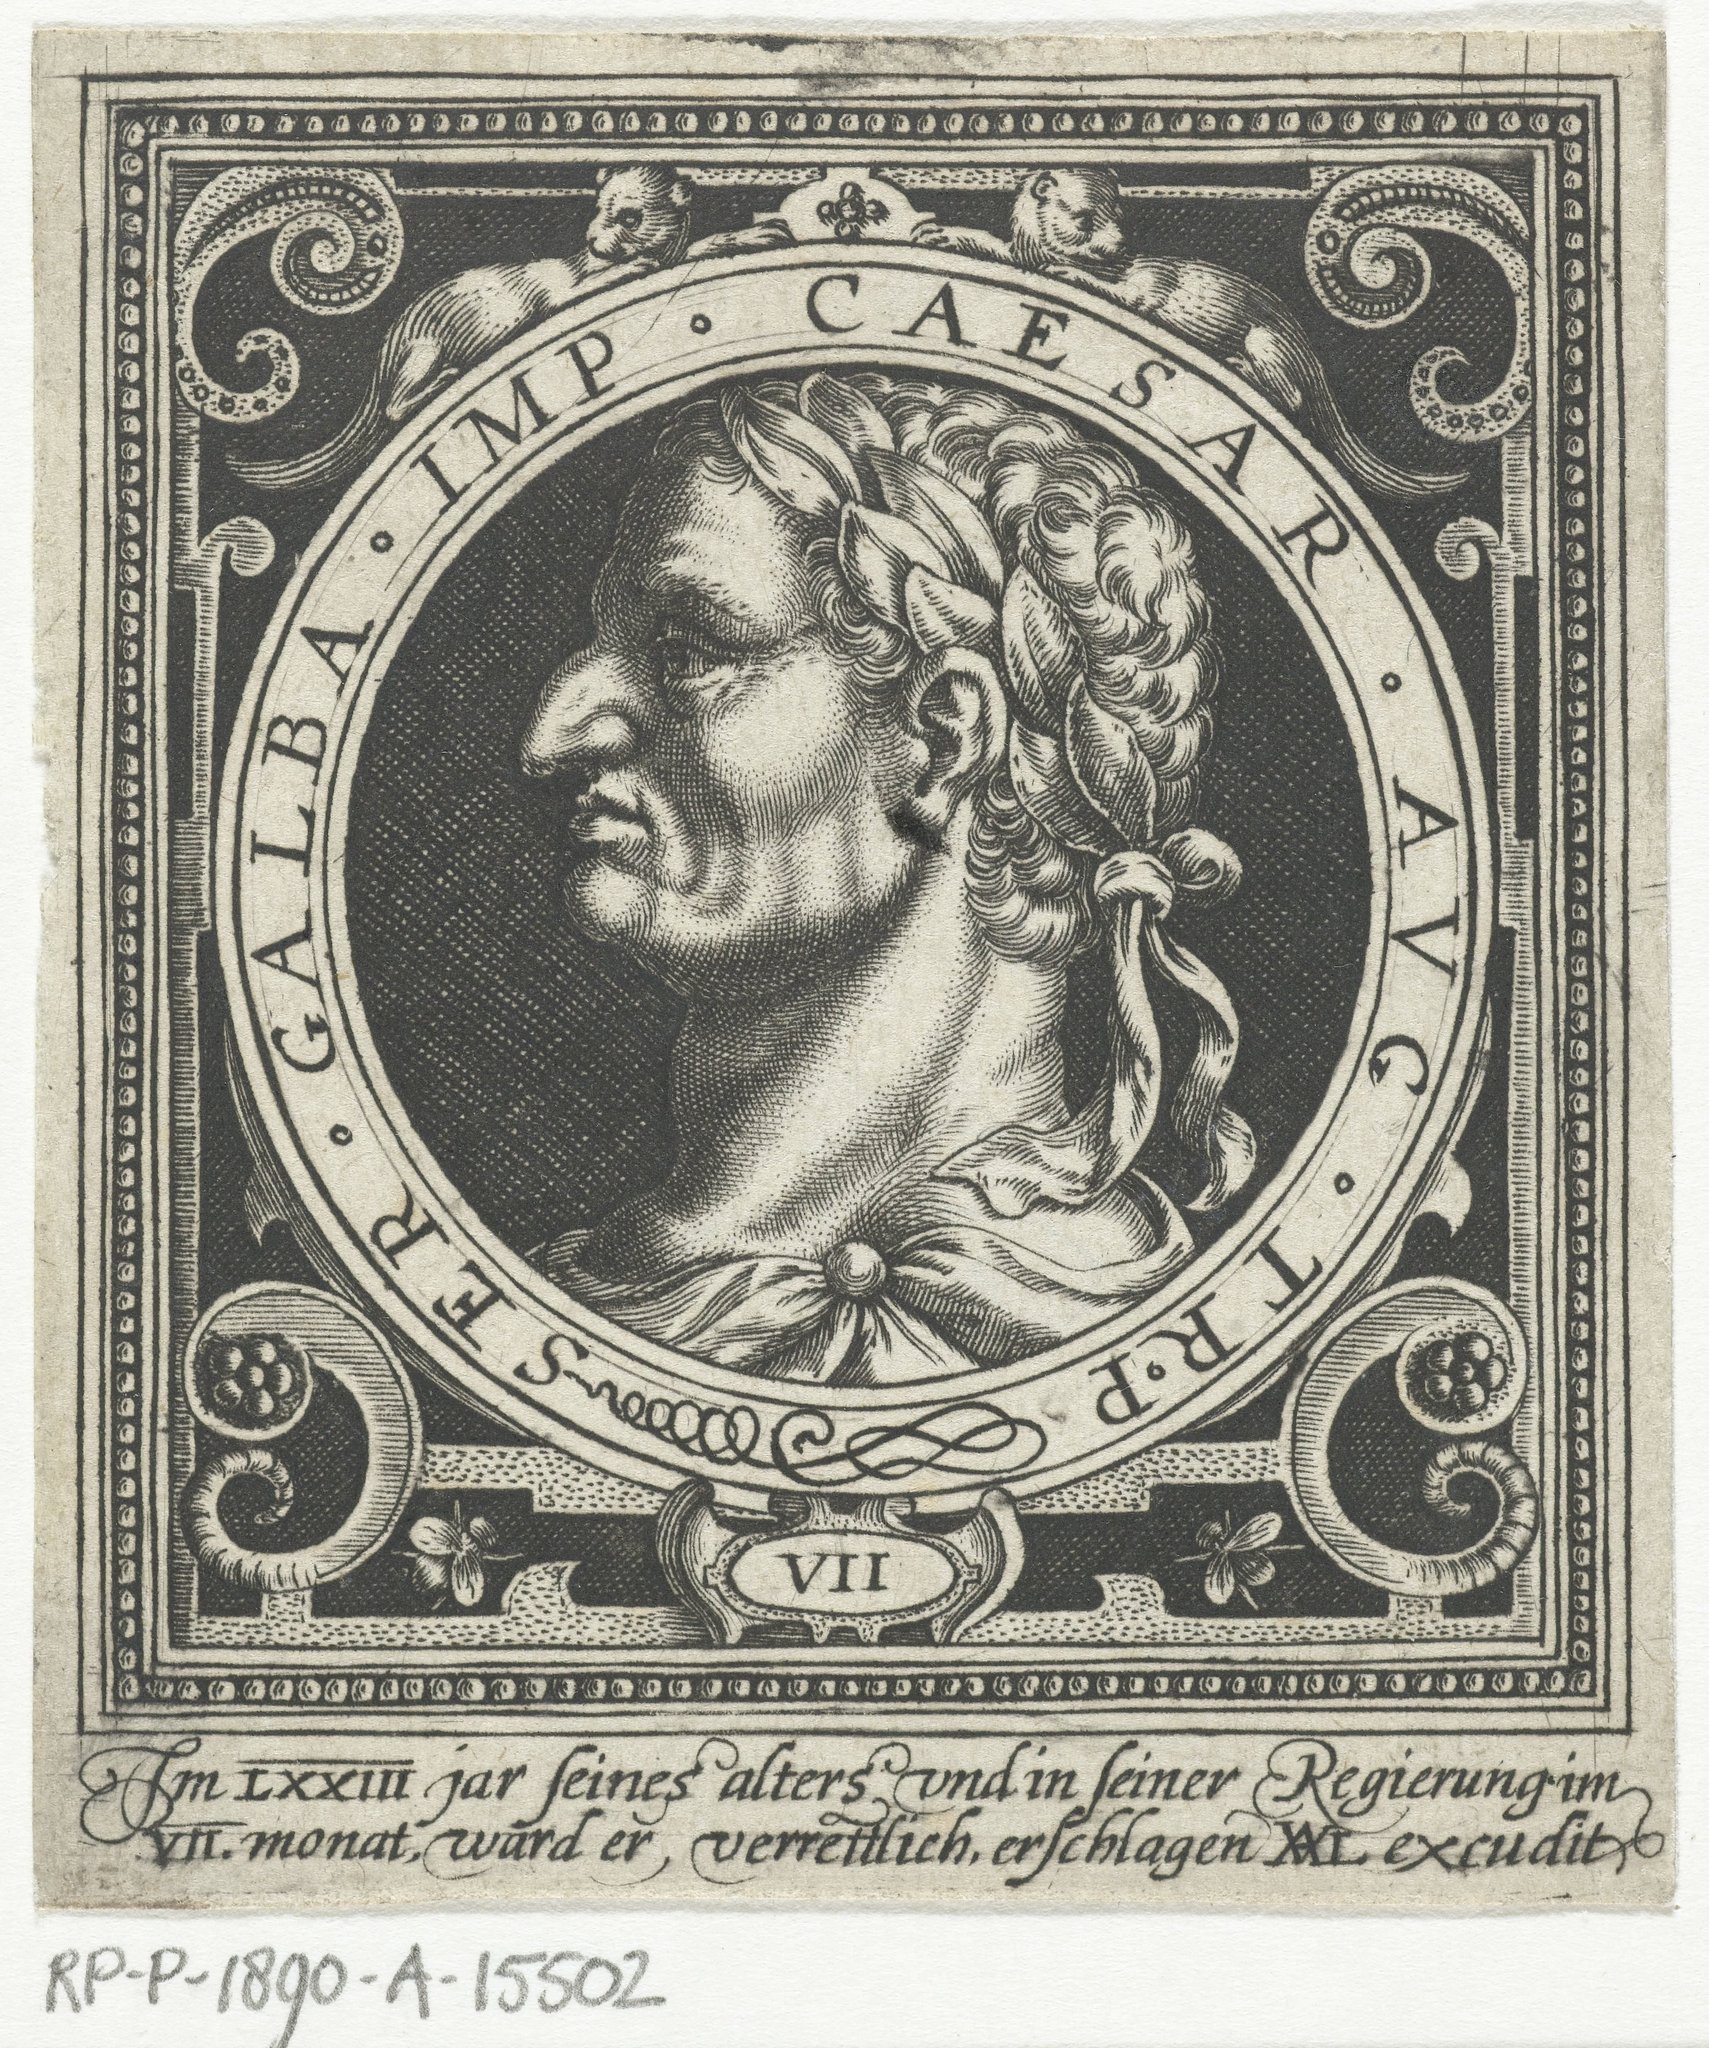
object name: print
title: Romeinse keizers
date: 1594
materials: paper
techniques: engraving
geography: netherlands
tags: male persons from classical history (galba)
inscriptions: collector's mark: Lugt 2228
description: Portret met buste van keizer Galba op medaillon in rechthoekige omlijsting met ornamenten. Op rand van medaillon titel en naam van keizer. In de marge onder twee regels in Duits over de wijze waarop de keizer om het leven kwam.